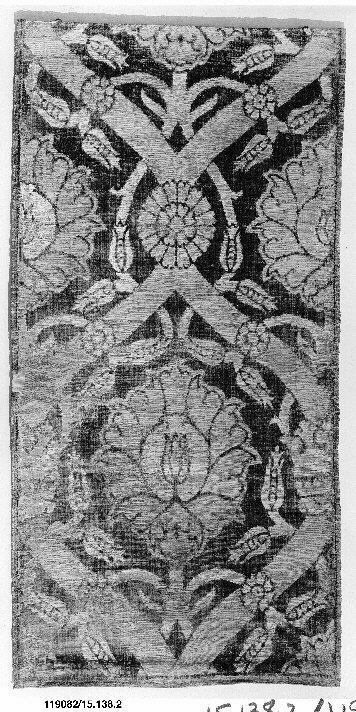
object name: textile fragment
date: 1501-1600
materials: metal thread, silk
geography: turkey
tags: flowers